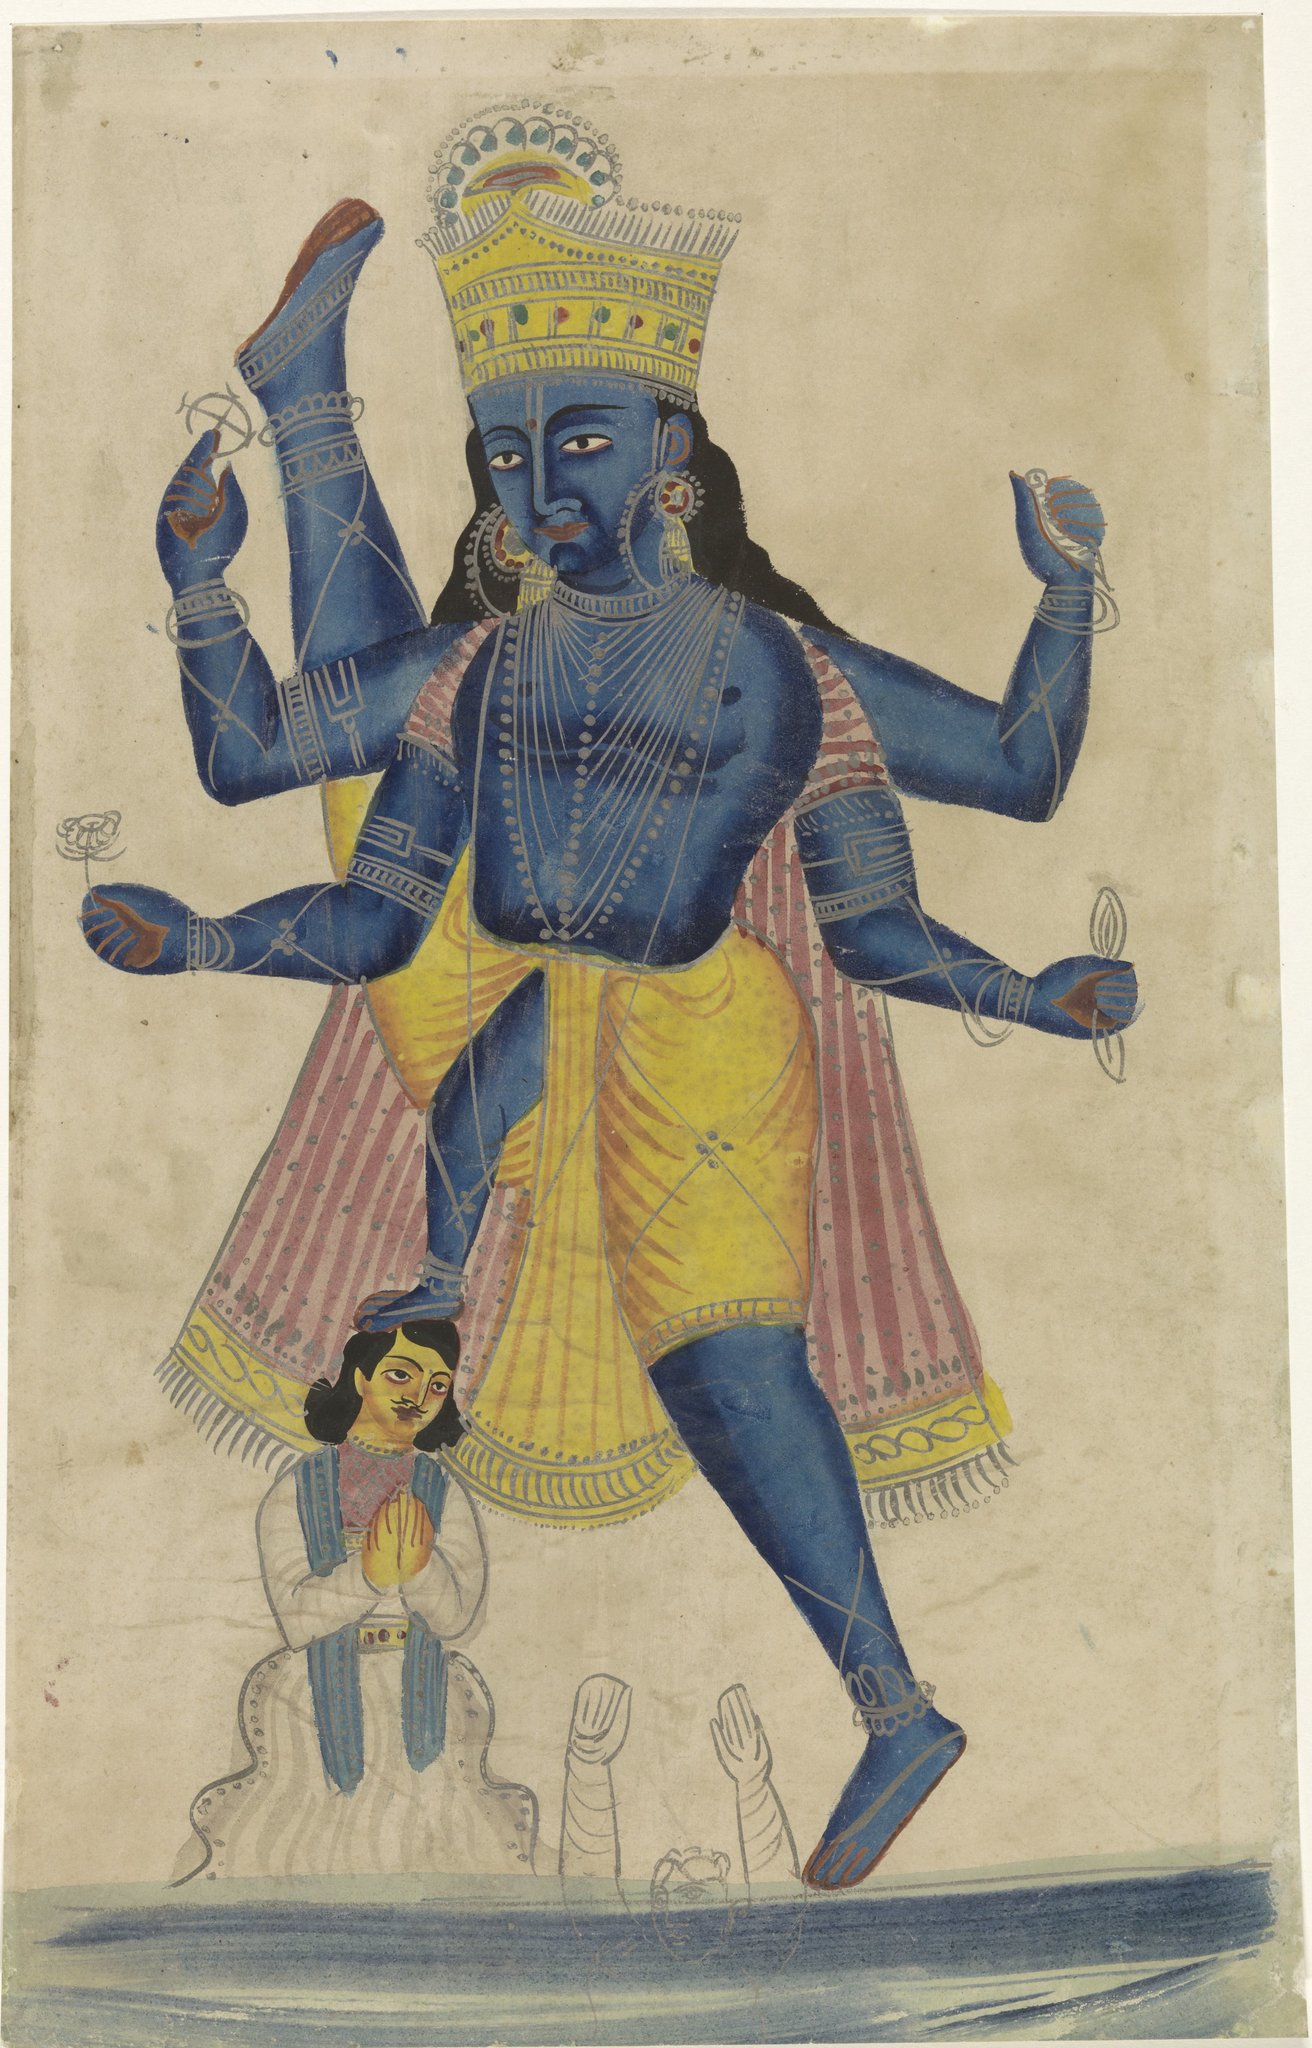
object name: indian miniature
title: Vamana (Trivikrama) avatar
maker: Anonymous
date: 1800-1900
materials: paper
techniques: brush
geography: kalighat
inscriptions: inscription: ‘Sabitree Satyabana’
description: Vamana (de kleine mens) is de vijfde incarnatie (avatara, letterlijk: 'nederdaling') van Vishnu. In een gevecht tussen de goden en de demonen hebben de goden het onderspit gedolven. Vishnu verschijnt dan in de gedaante van een kleine mens en vraagt de koning van de demonen, Bali, om een klein stukje grond die hij in drie stappen kan betreden. Bali stemt in. Vishnu verandert in een reuzenfiguur en stapt over de aarde, de onderwereld en over de hemelen. Volgens een andere overlevering met een stap verovert hij de hemel en de aarde, met de tweede stap het universum. Omdat er geen plaats is voor de derde stap, biedt Bali zijn eigen hoofd aan. Deze vorm van Vishnu wordt ook Trivikrama (Sanskrit: drie stappen) genoemd.